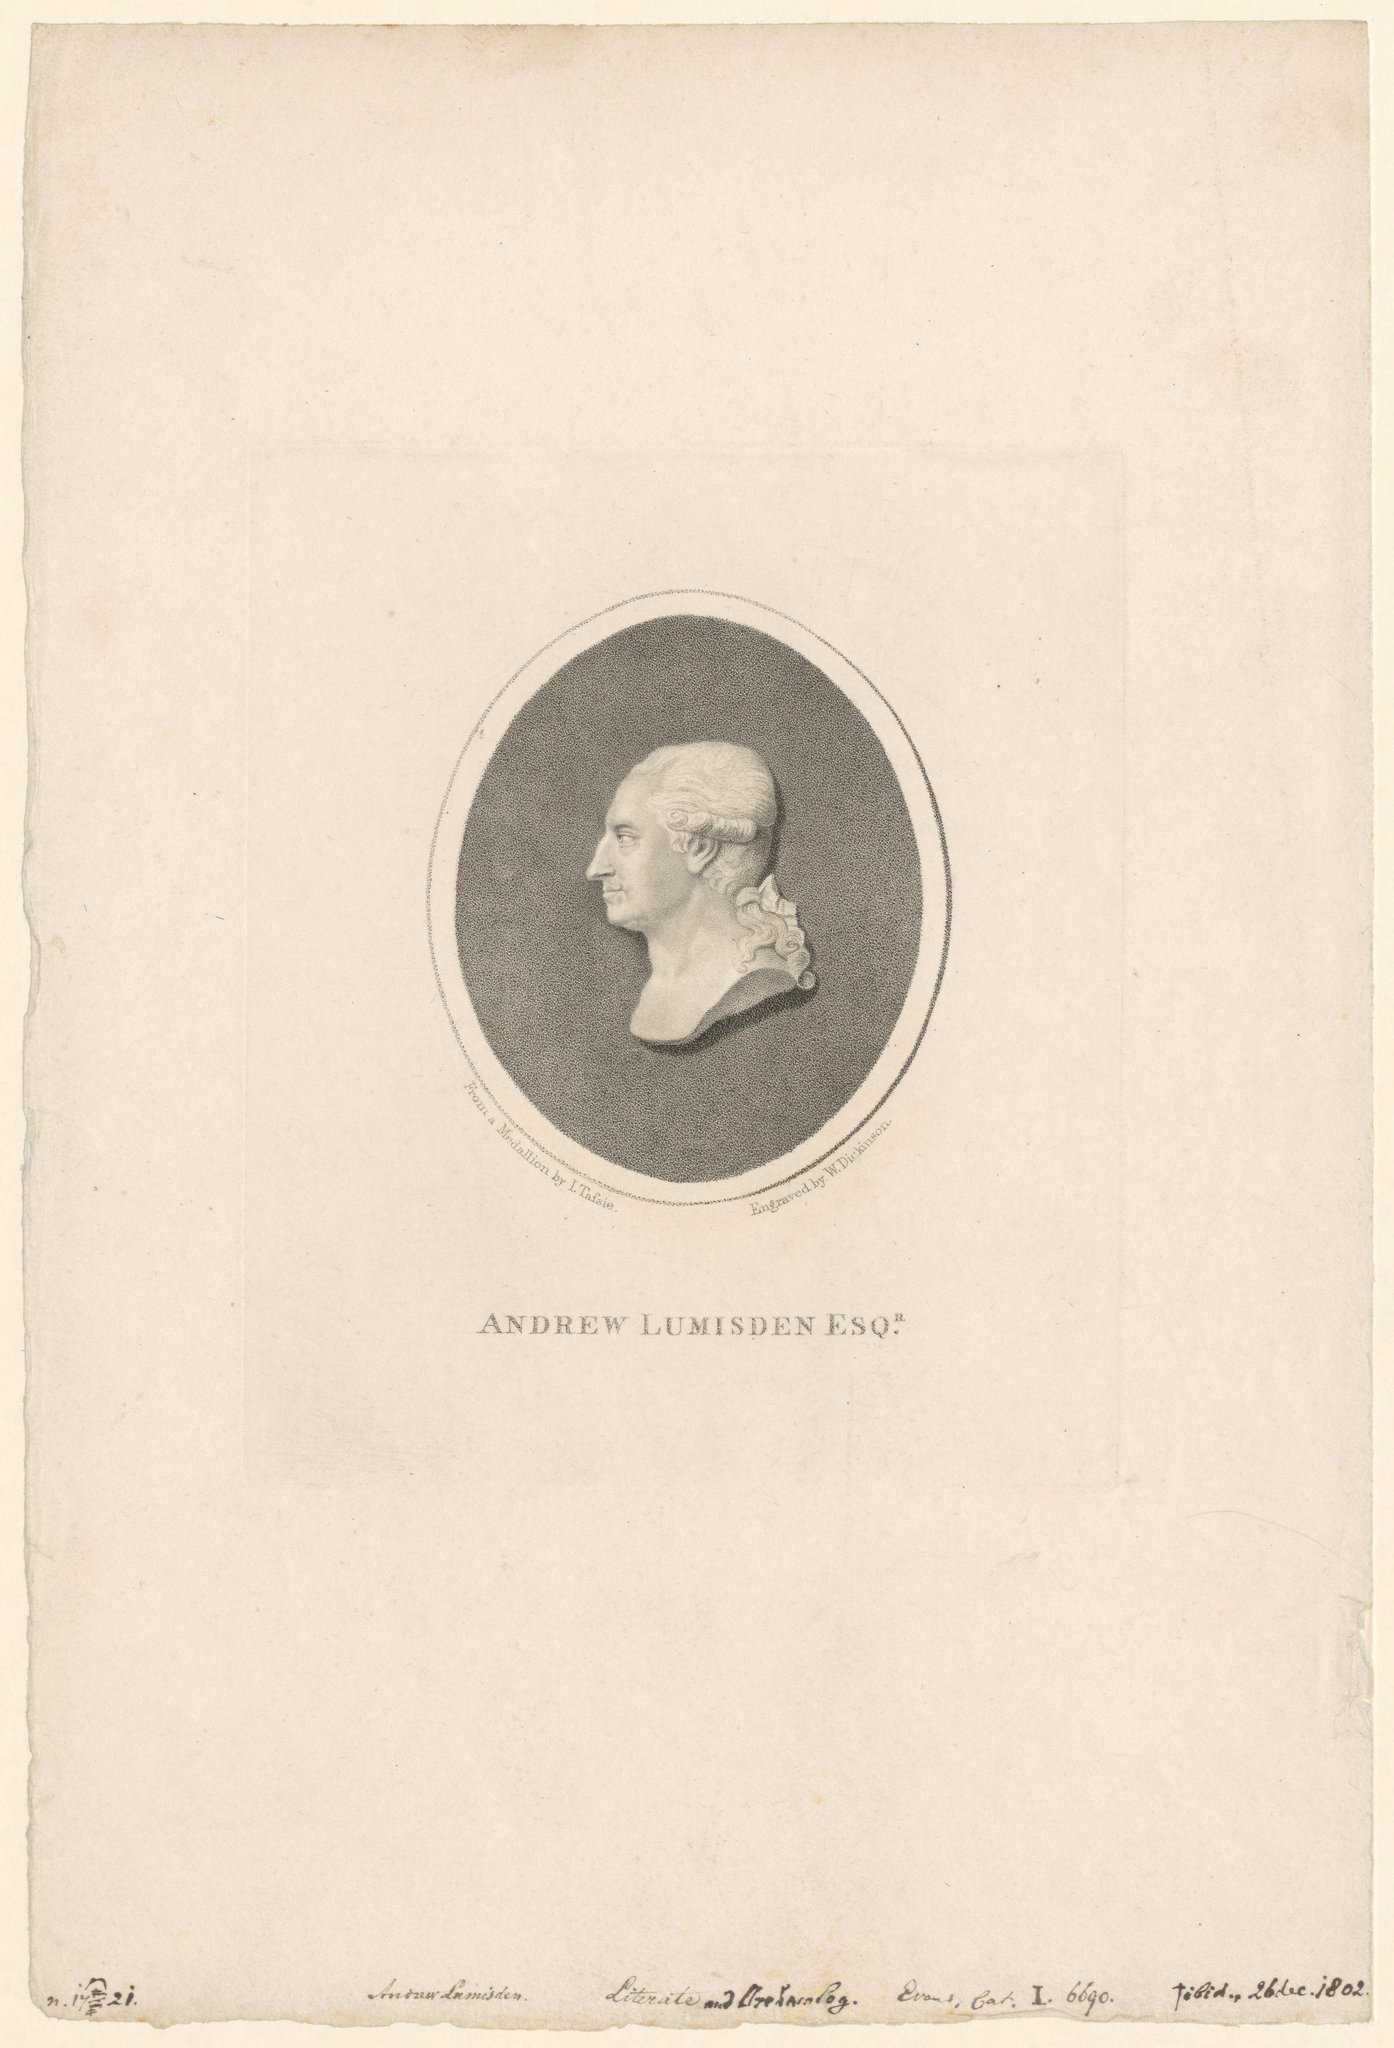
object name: print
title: Portret van Andrew Lumisden Esqr.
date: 1756-1823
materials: paper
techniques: stippling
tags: historical persons, officer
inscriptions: collector's mark: Lugt 2228, annotation: ‘Andrew Lemisden, Literate and [...] Evans, Cat I. 6690’